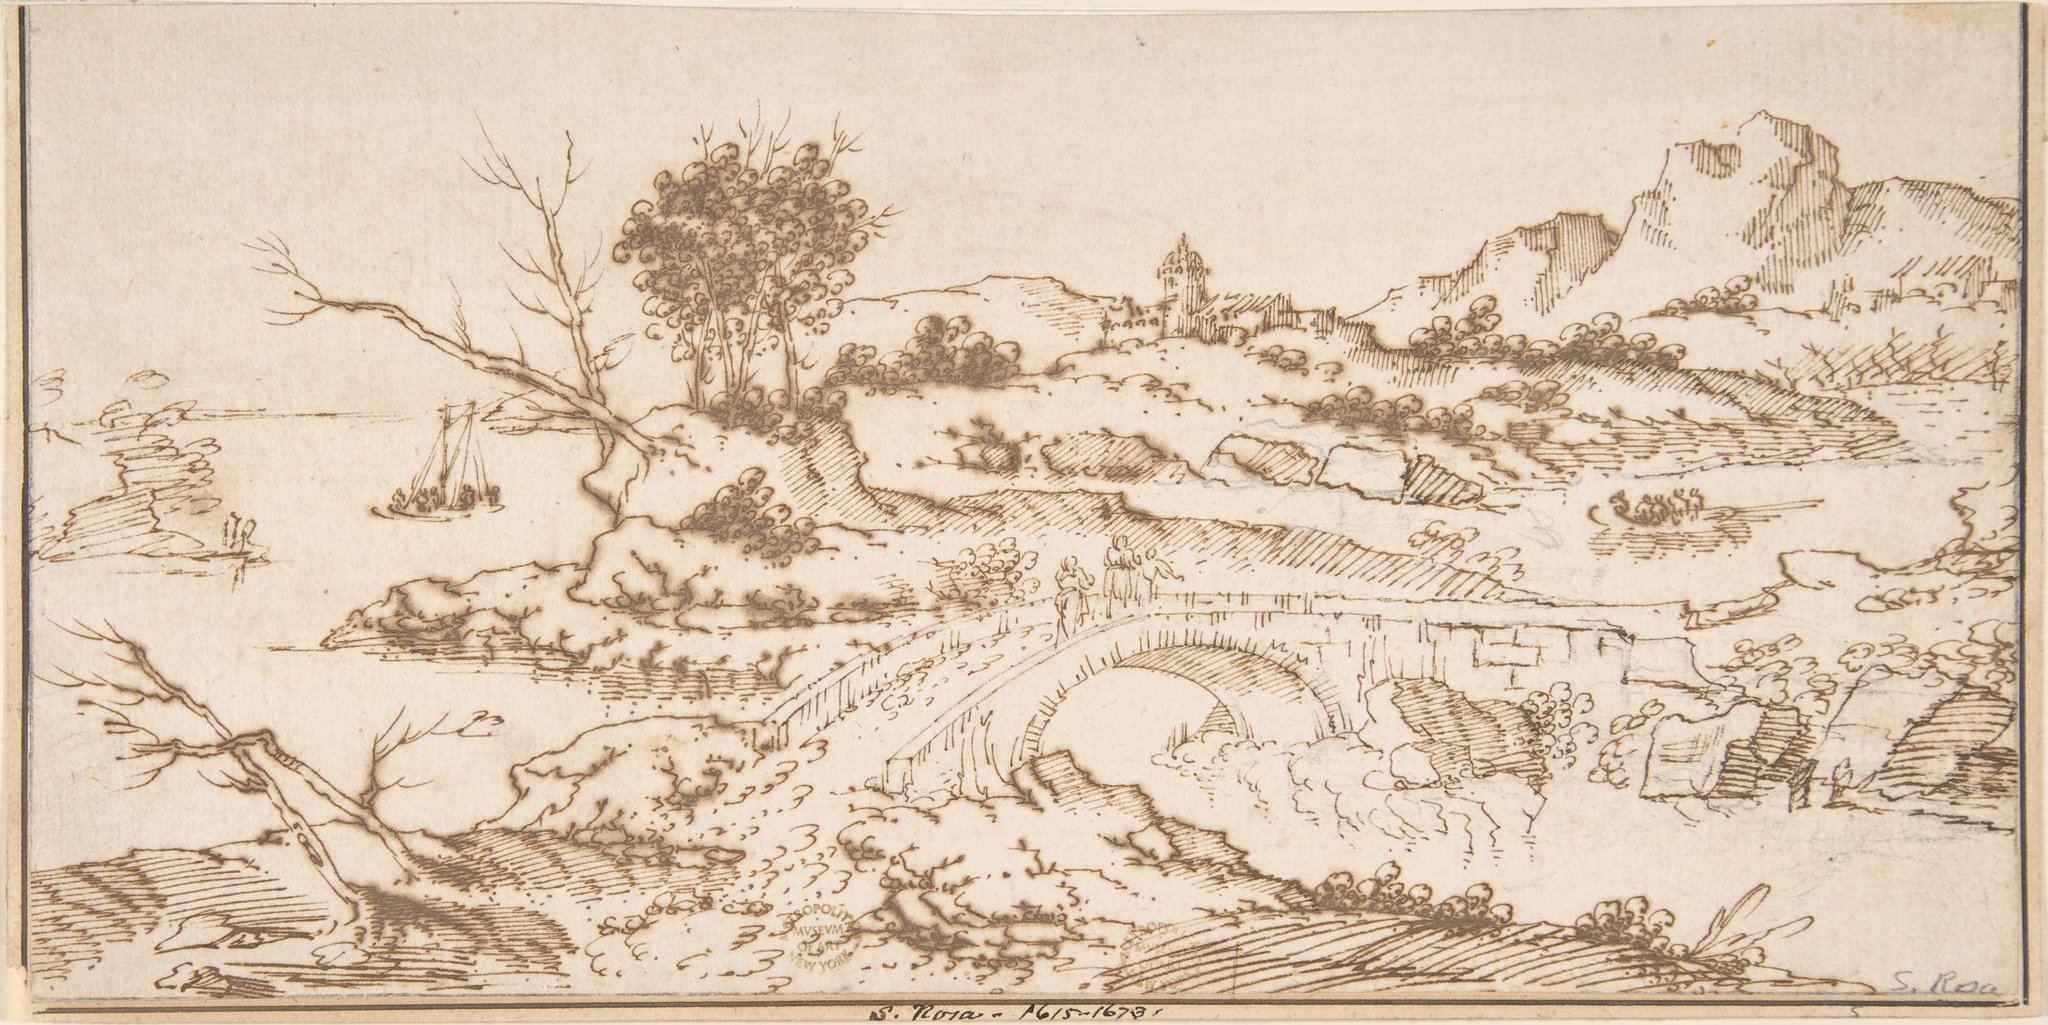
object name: drawing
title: Landscape With Figures Crossing a Bridge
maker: anonymous, italian, roman-bolognese, 17th century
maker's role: artist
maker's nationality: italian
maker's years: 1600-1700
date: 1601-1700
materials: chalk, ink, paper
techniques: pen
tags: bridges,landscapes